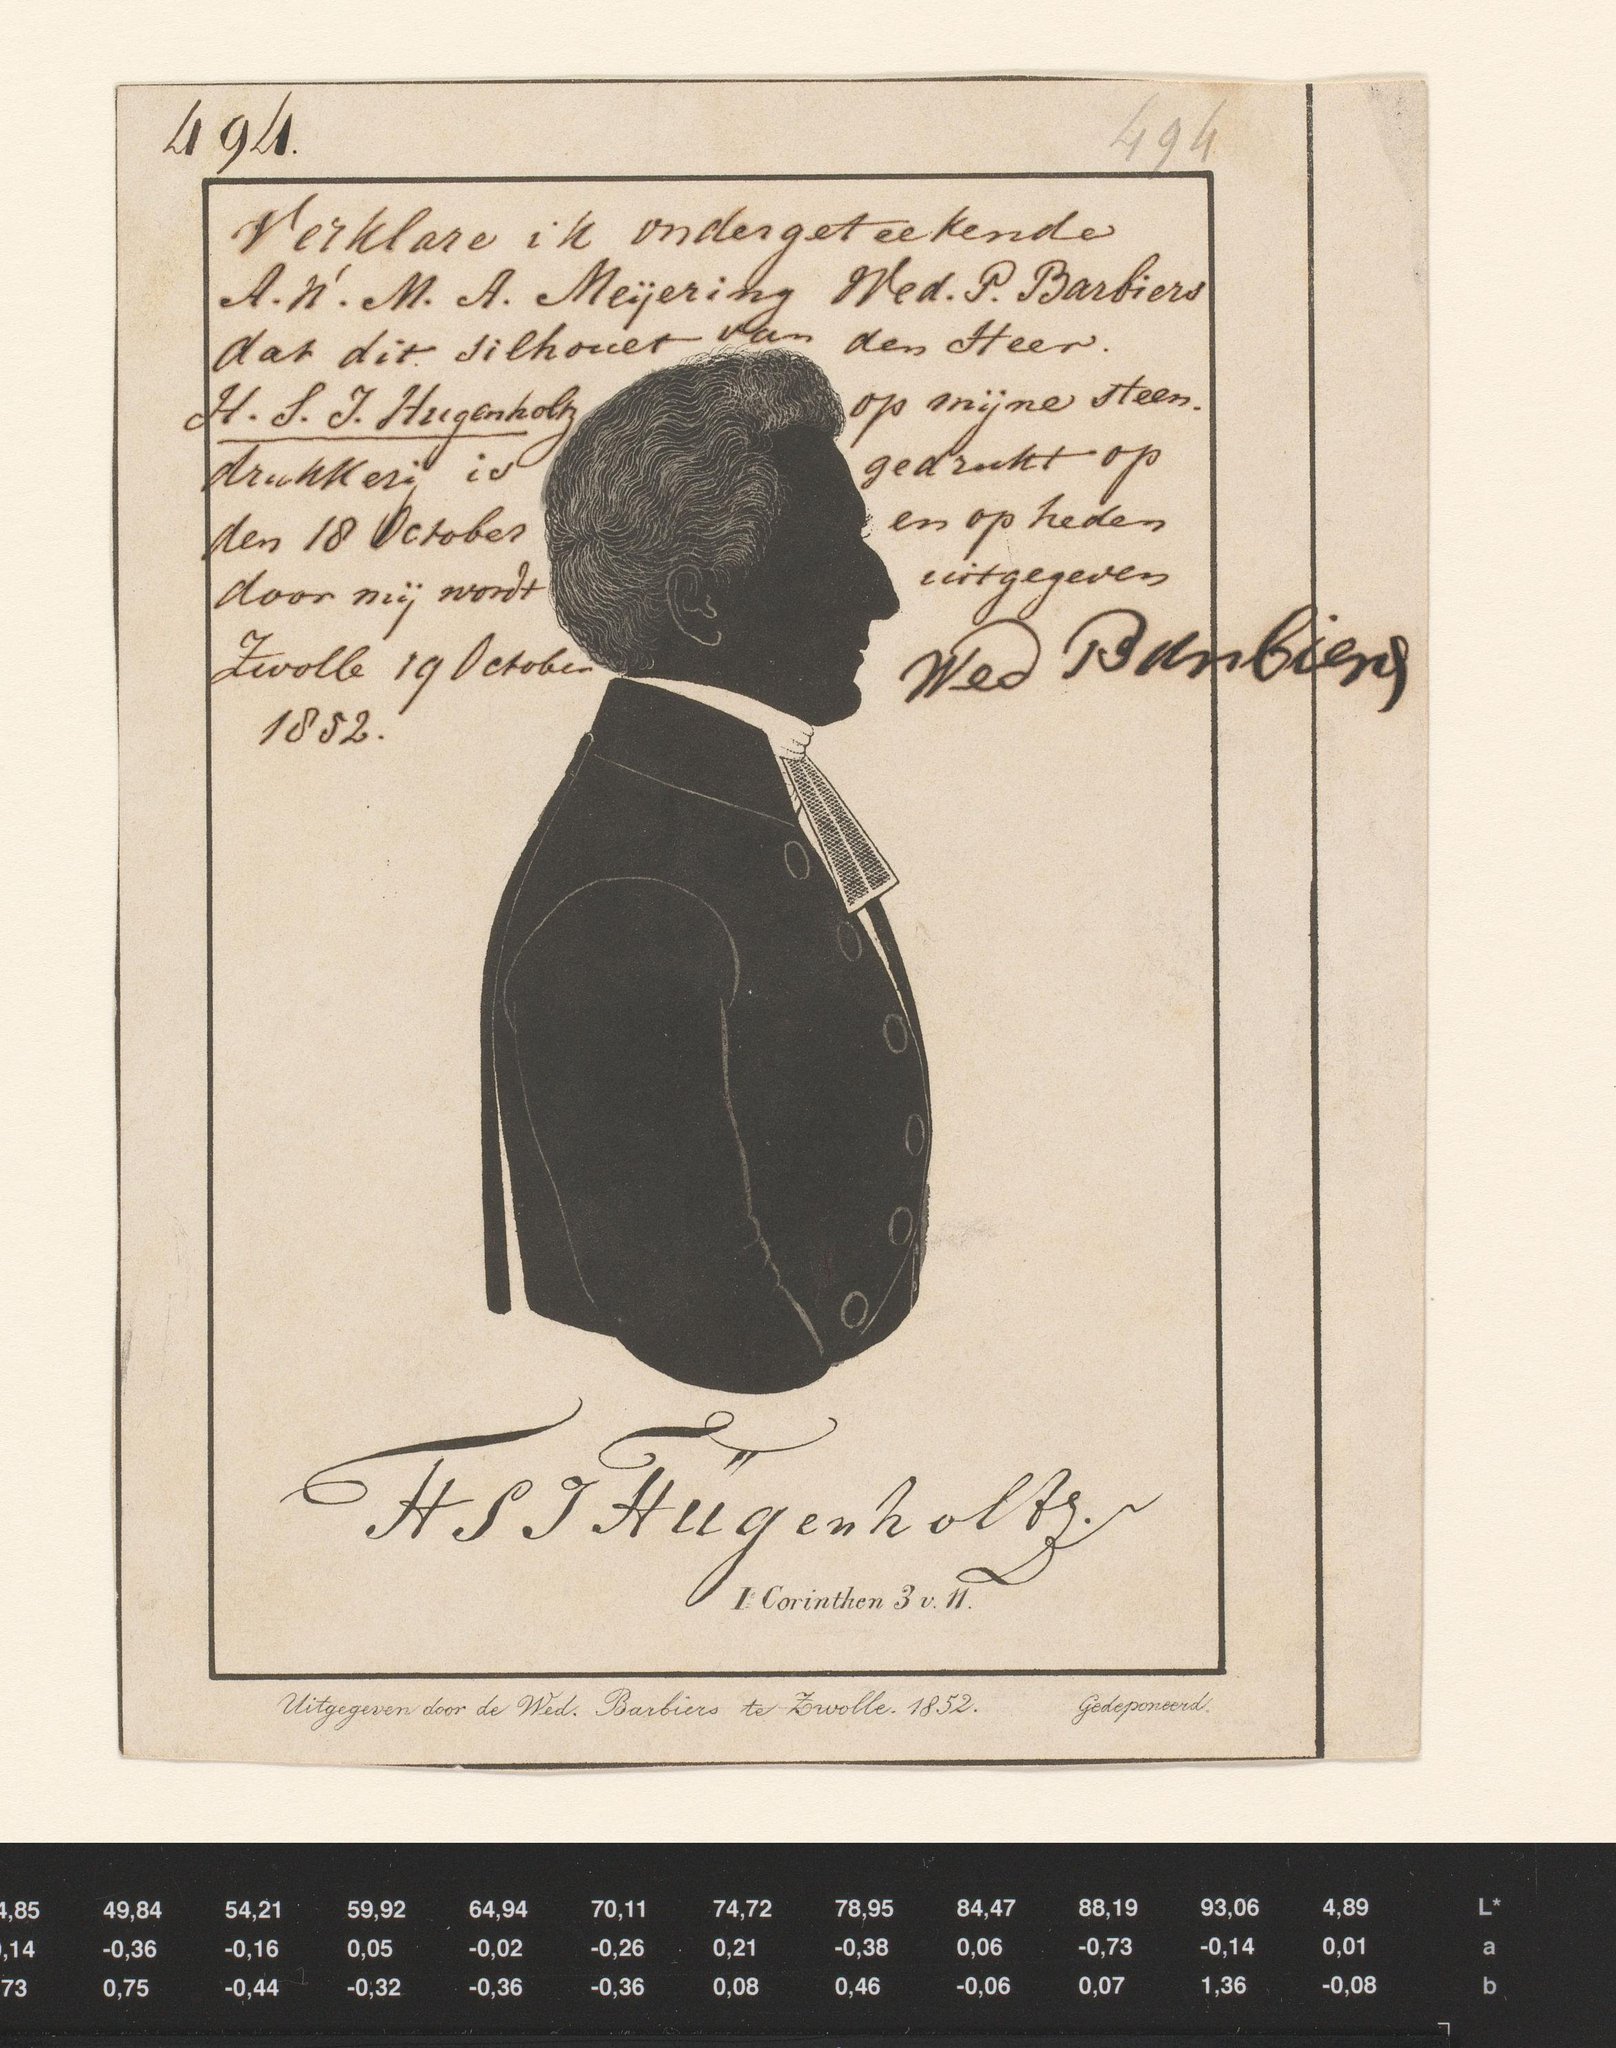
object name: print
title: Silhouetportret van Henricus Stephanus Johannes Hugenholtz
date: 1852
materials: paper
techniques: hand coloring, lithograph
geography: zwolle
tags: historical persons, functionaries and dignitaries ~ protestant churches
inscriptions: : ‘494. / Verklare ik ondergetekeende / A.N.M.A. Meijering Wed. P. Barbiers / dat dit silhouet van den heer. / H.S.J. Hugenholtz [onderstreept] op mijne steen. / drukkerij is gedrukt op / den 18 October en op heden / door mij wordt uitgegeven / Zwolle 19 October Wed Barbiers / 1852.’, : ‘Gedeponeerd.’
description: Onderaan: facsimile handtekening van de geportretteerde.